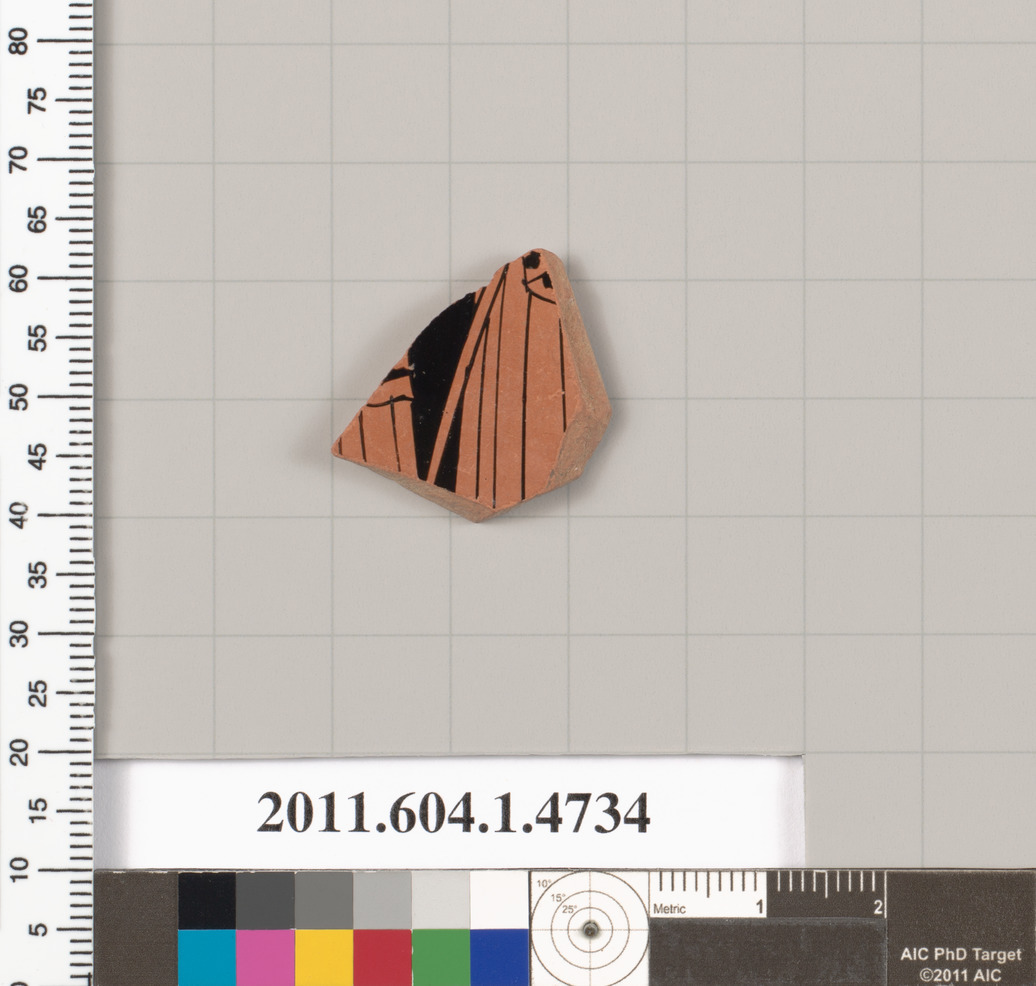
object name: kylix fragment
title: Terracotta fragment of a kylix (drinking cup)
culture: greek, attic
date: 475-451 BCE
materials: terracotta